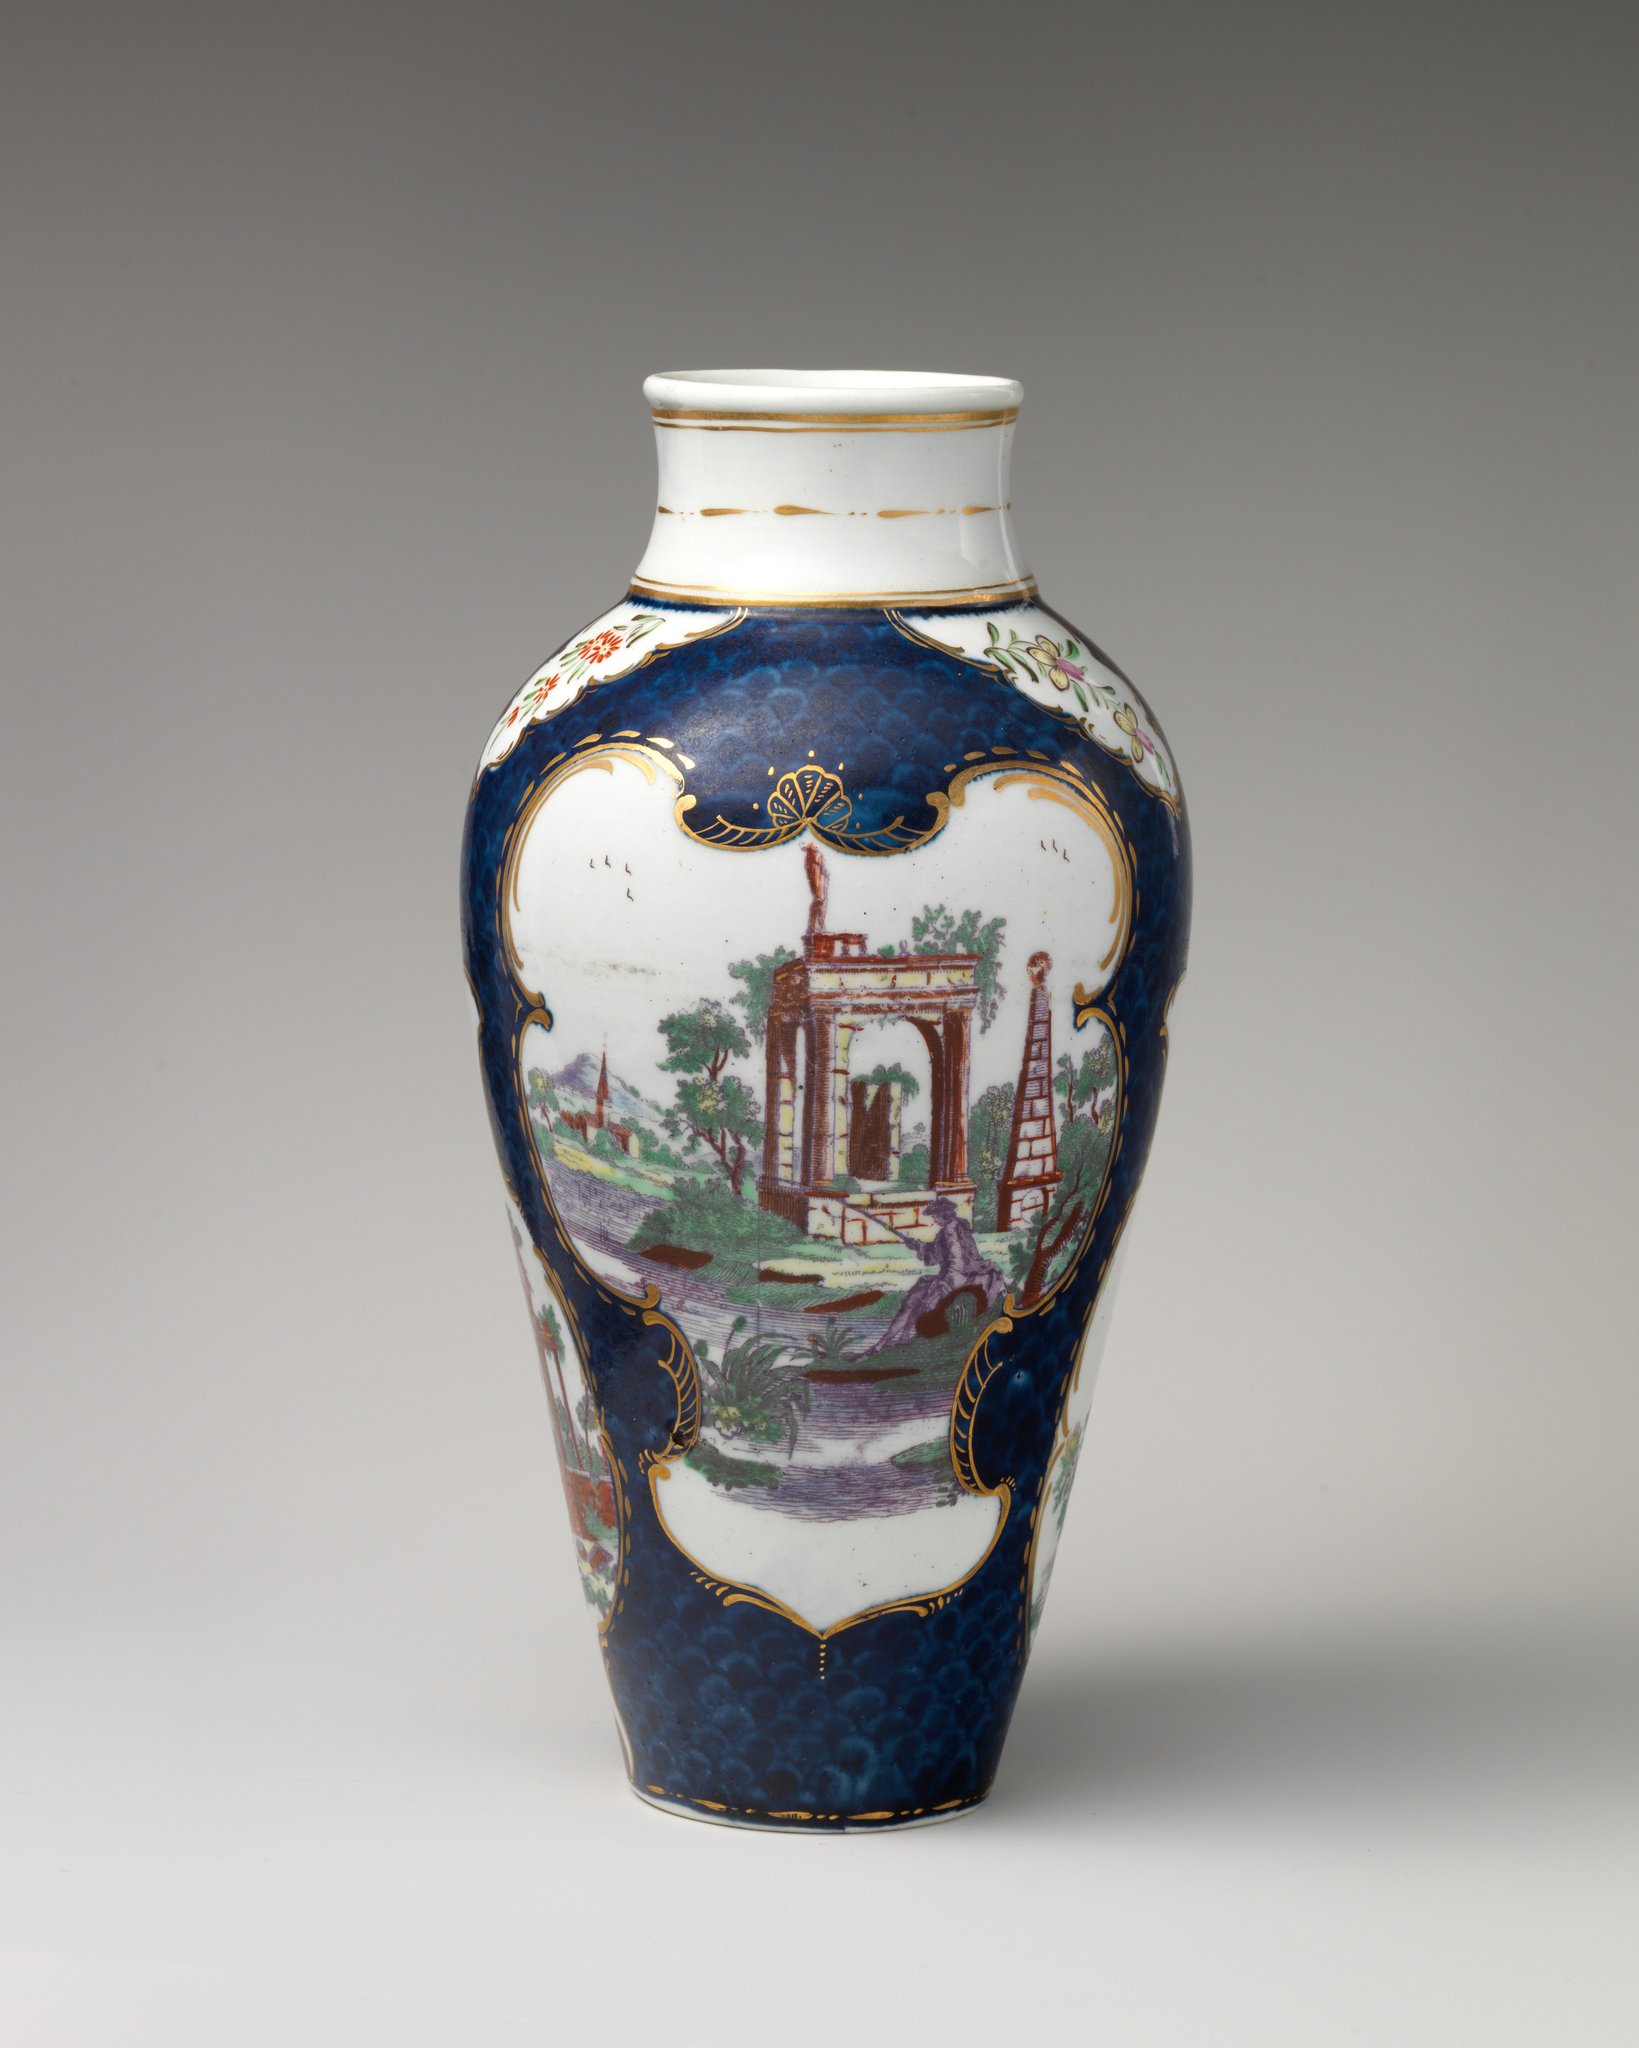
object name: vase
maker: worcester factory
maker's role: factory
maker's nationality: british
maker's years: 1751-2008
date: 1770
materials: soft paste porcelain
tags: ruins,men,fishing